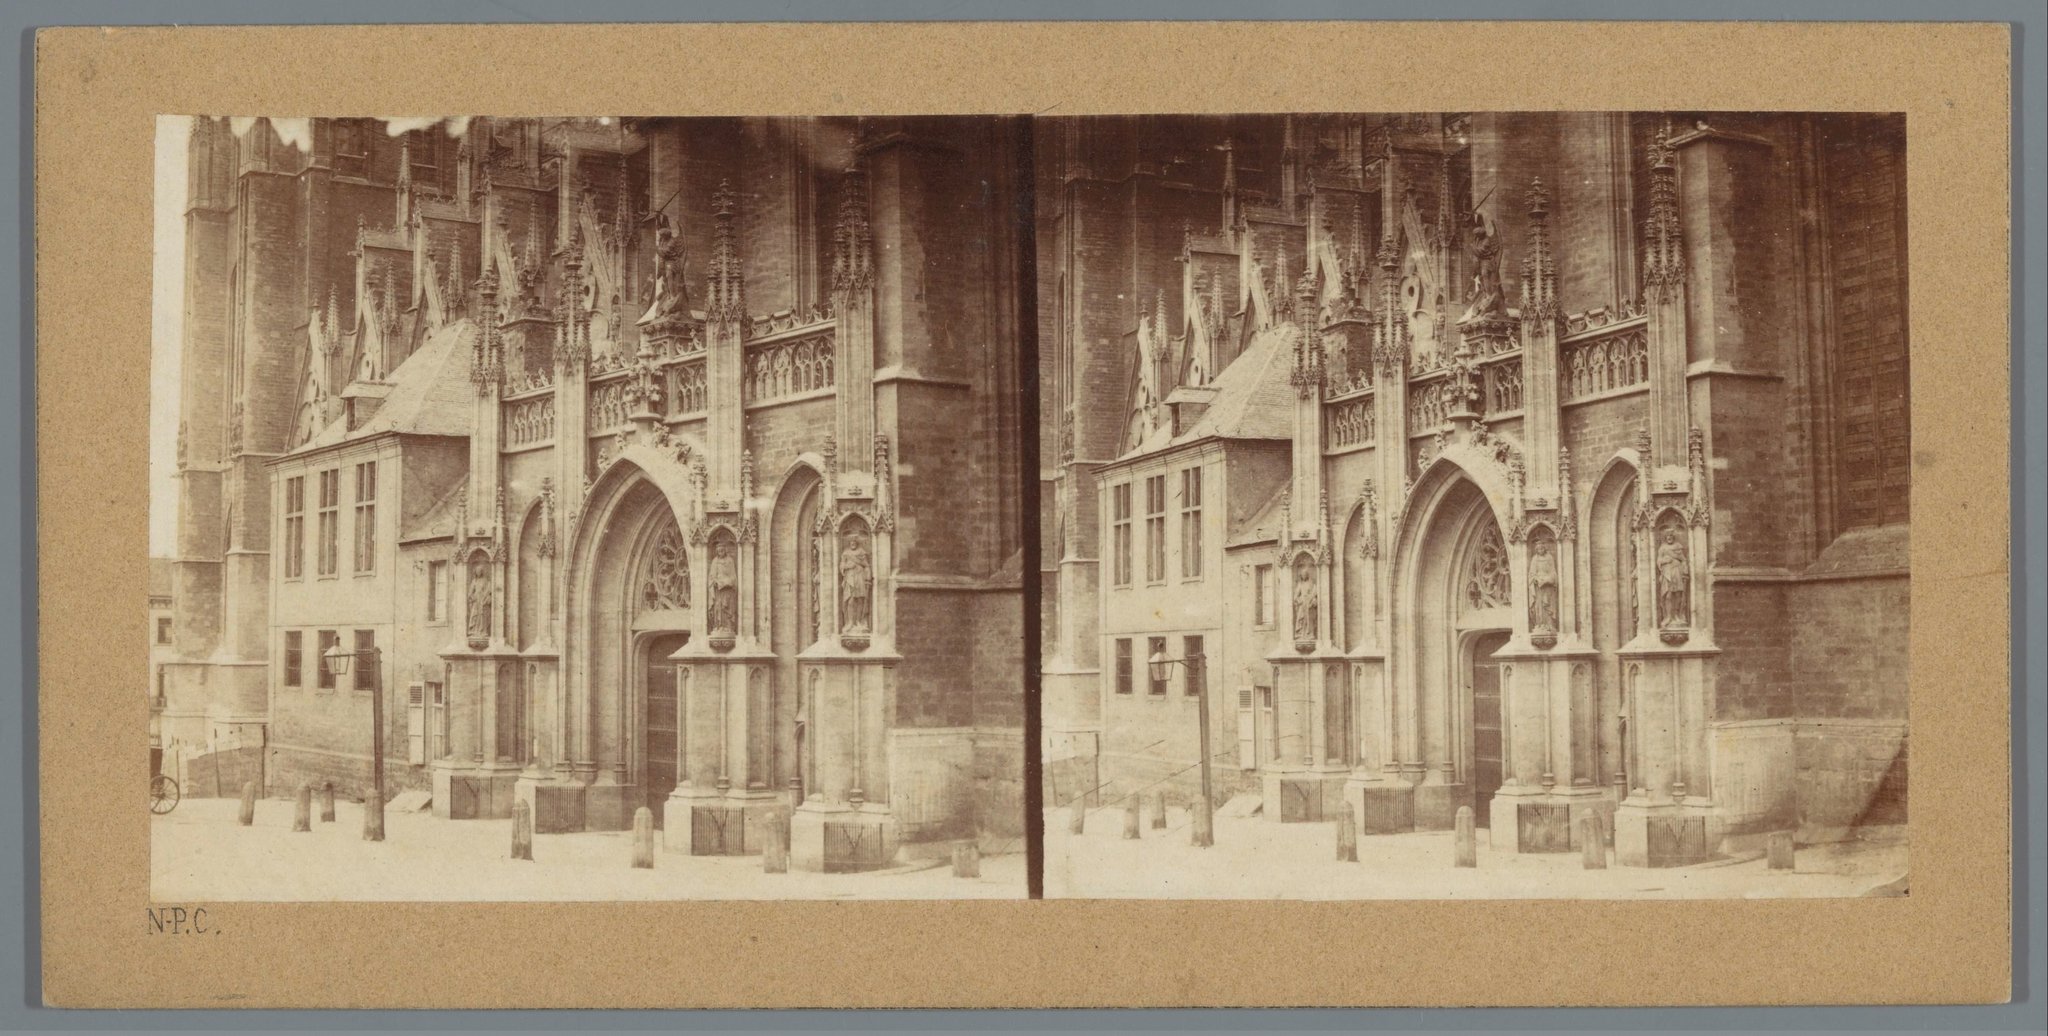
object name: stereograph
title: Gezicht op een zijportaal van de Kathedraal van Sint-Michiel en Sint-Goedele in Brussel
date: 1857-1863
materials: cardboard, paper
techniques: albumen print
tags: parts of church exterior and annexes: portal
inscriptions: number: ‘17’